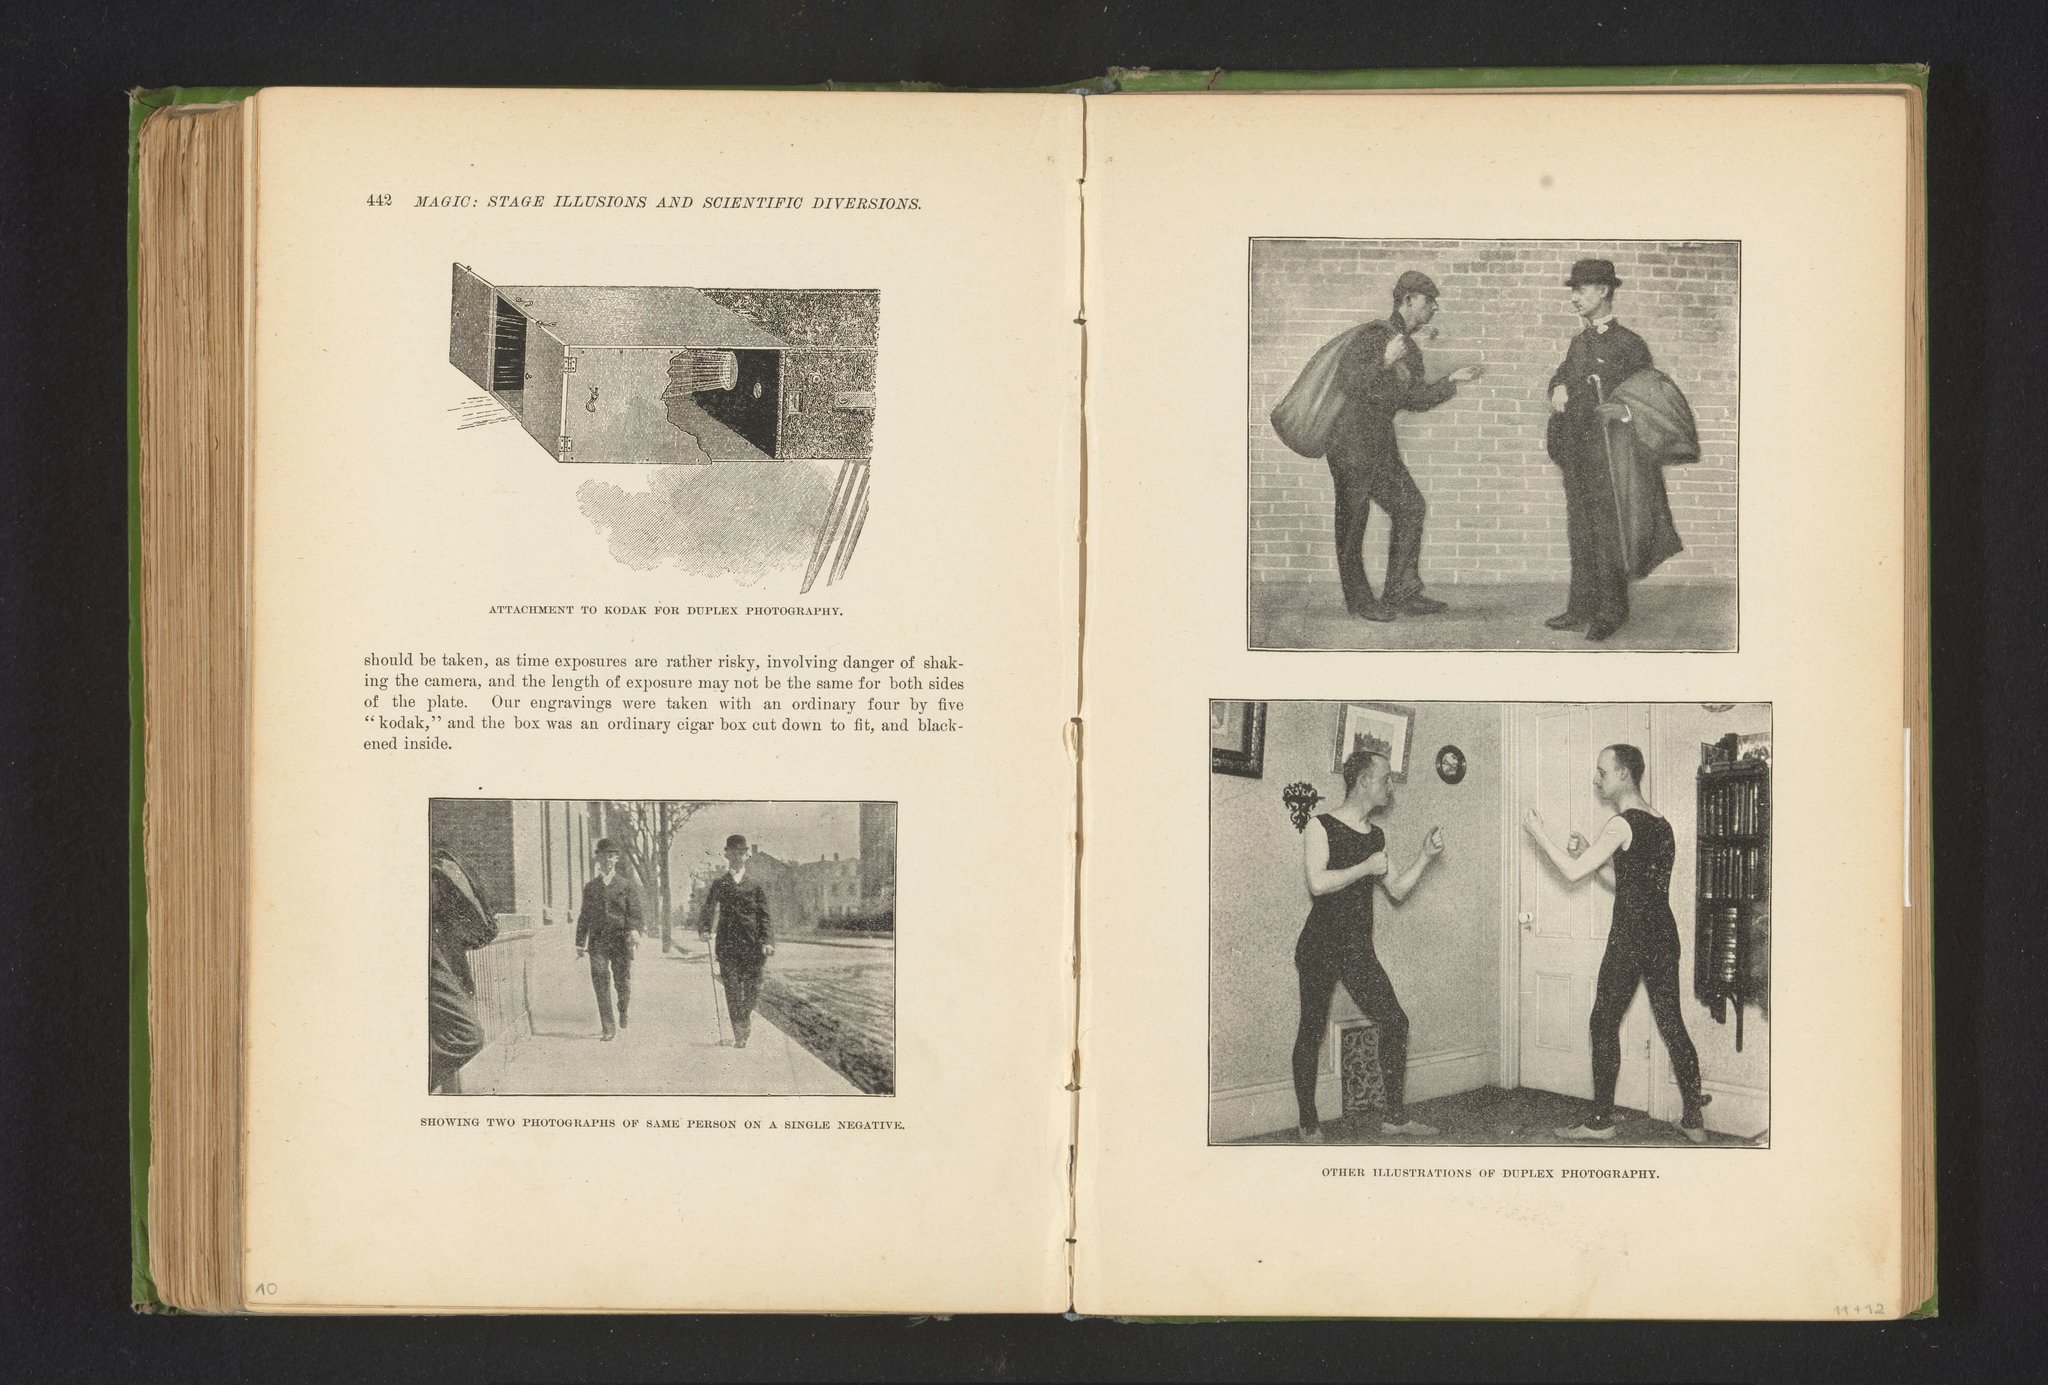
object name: page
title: Voorbeeld van twee foto's van een persoon op één negatief afgedrukt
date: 1892-1897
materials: paper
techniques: autotype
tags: adult man